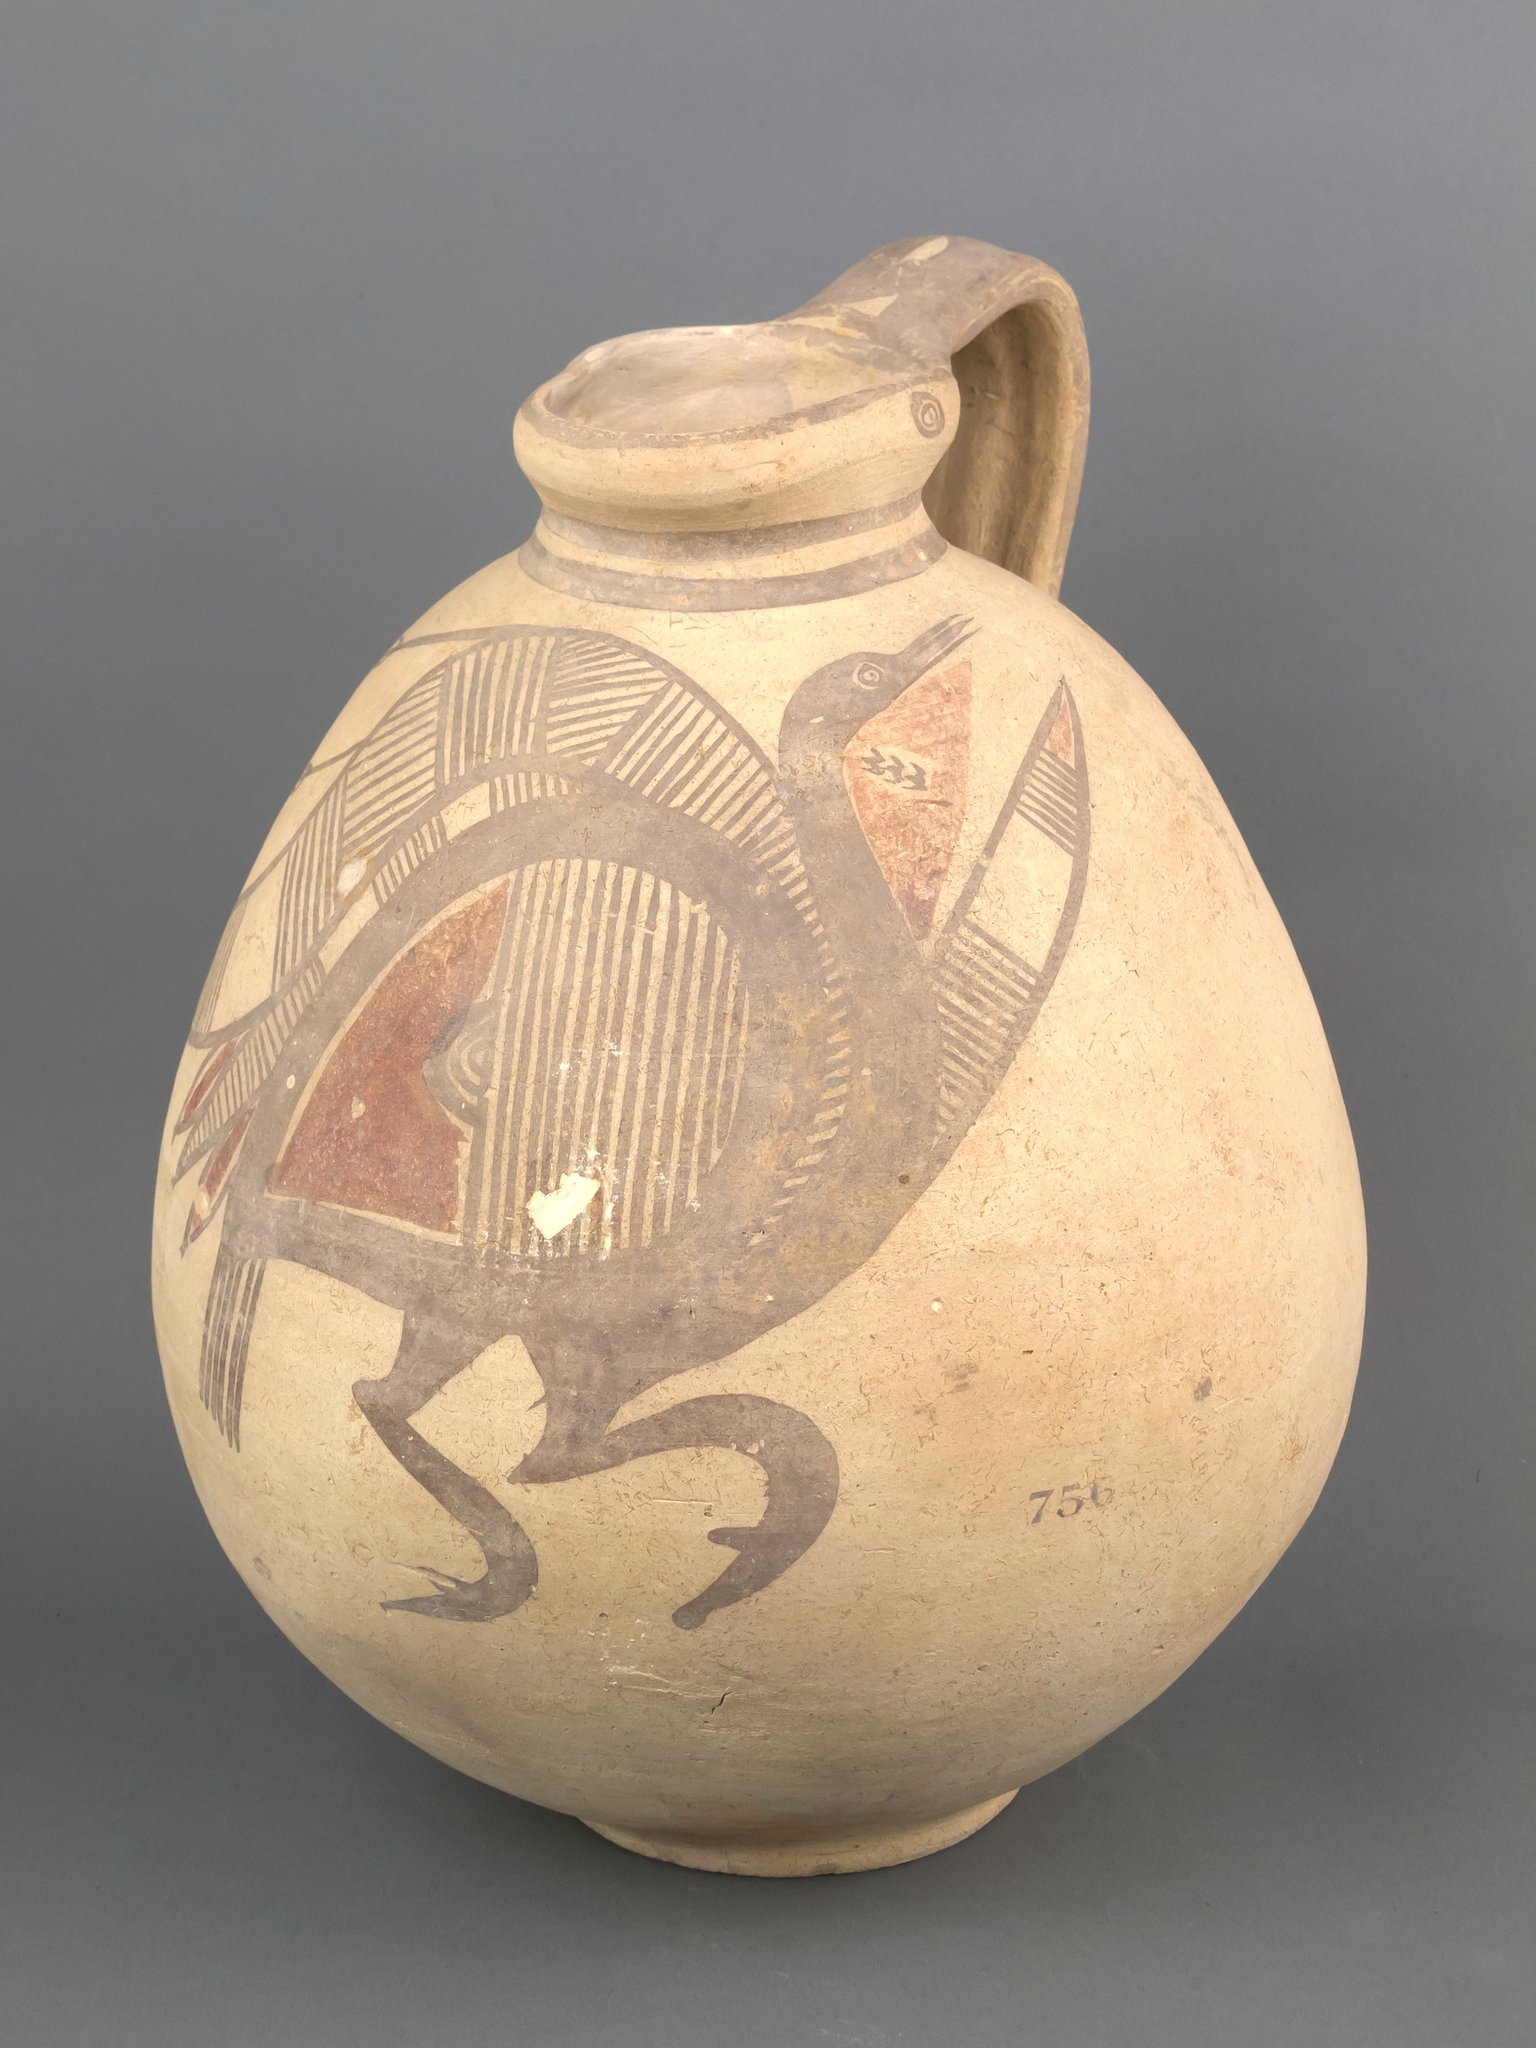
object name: jug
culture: cypriot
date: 750-600 BCE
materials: terracotta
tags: birds